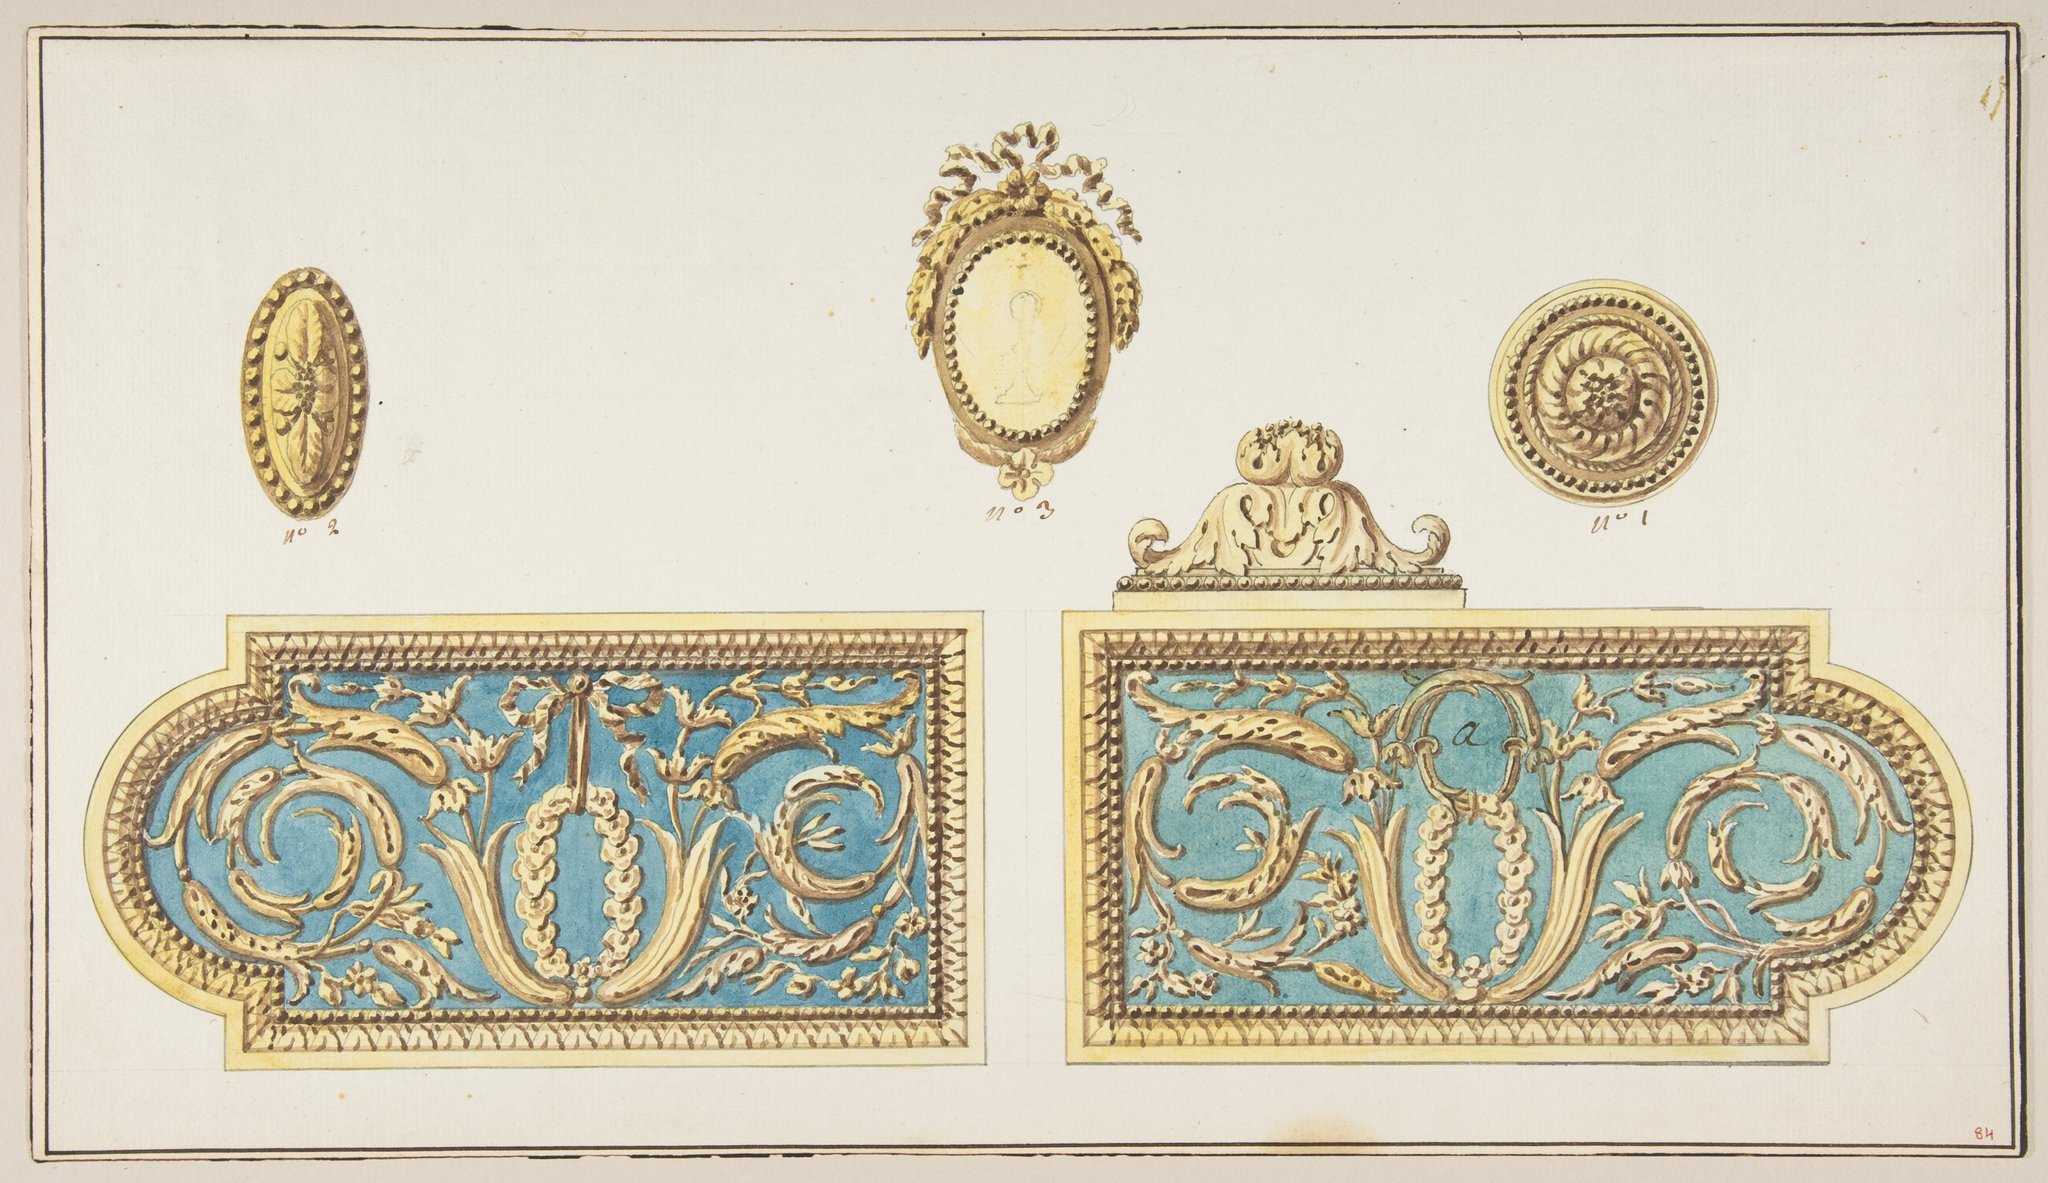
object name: drawing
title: Designs for Door Hardware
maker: anonymous, french, 18th century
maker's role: artist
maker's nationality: french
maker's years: 1700-1800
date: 1775-1785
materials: ink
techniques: brush, pen, wash